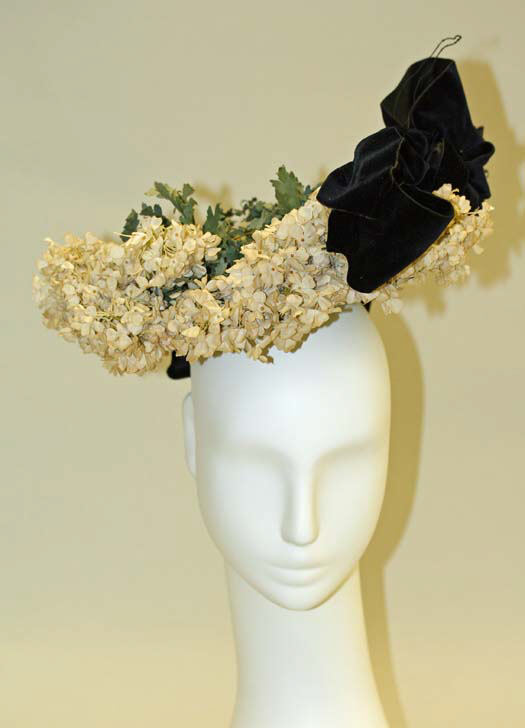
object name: hat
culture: european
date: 1900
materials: silk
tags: flowers